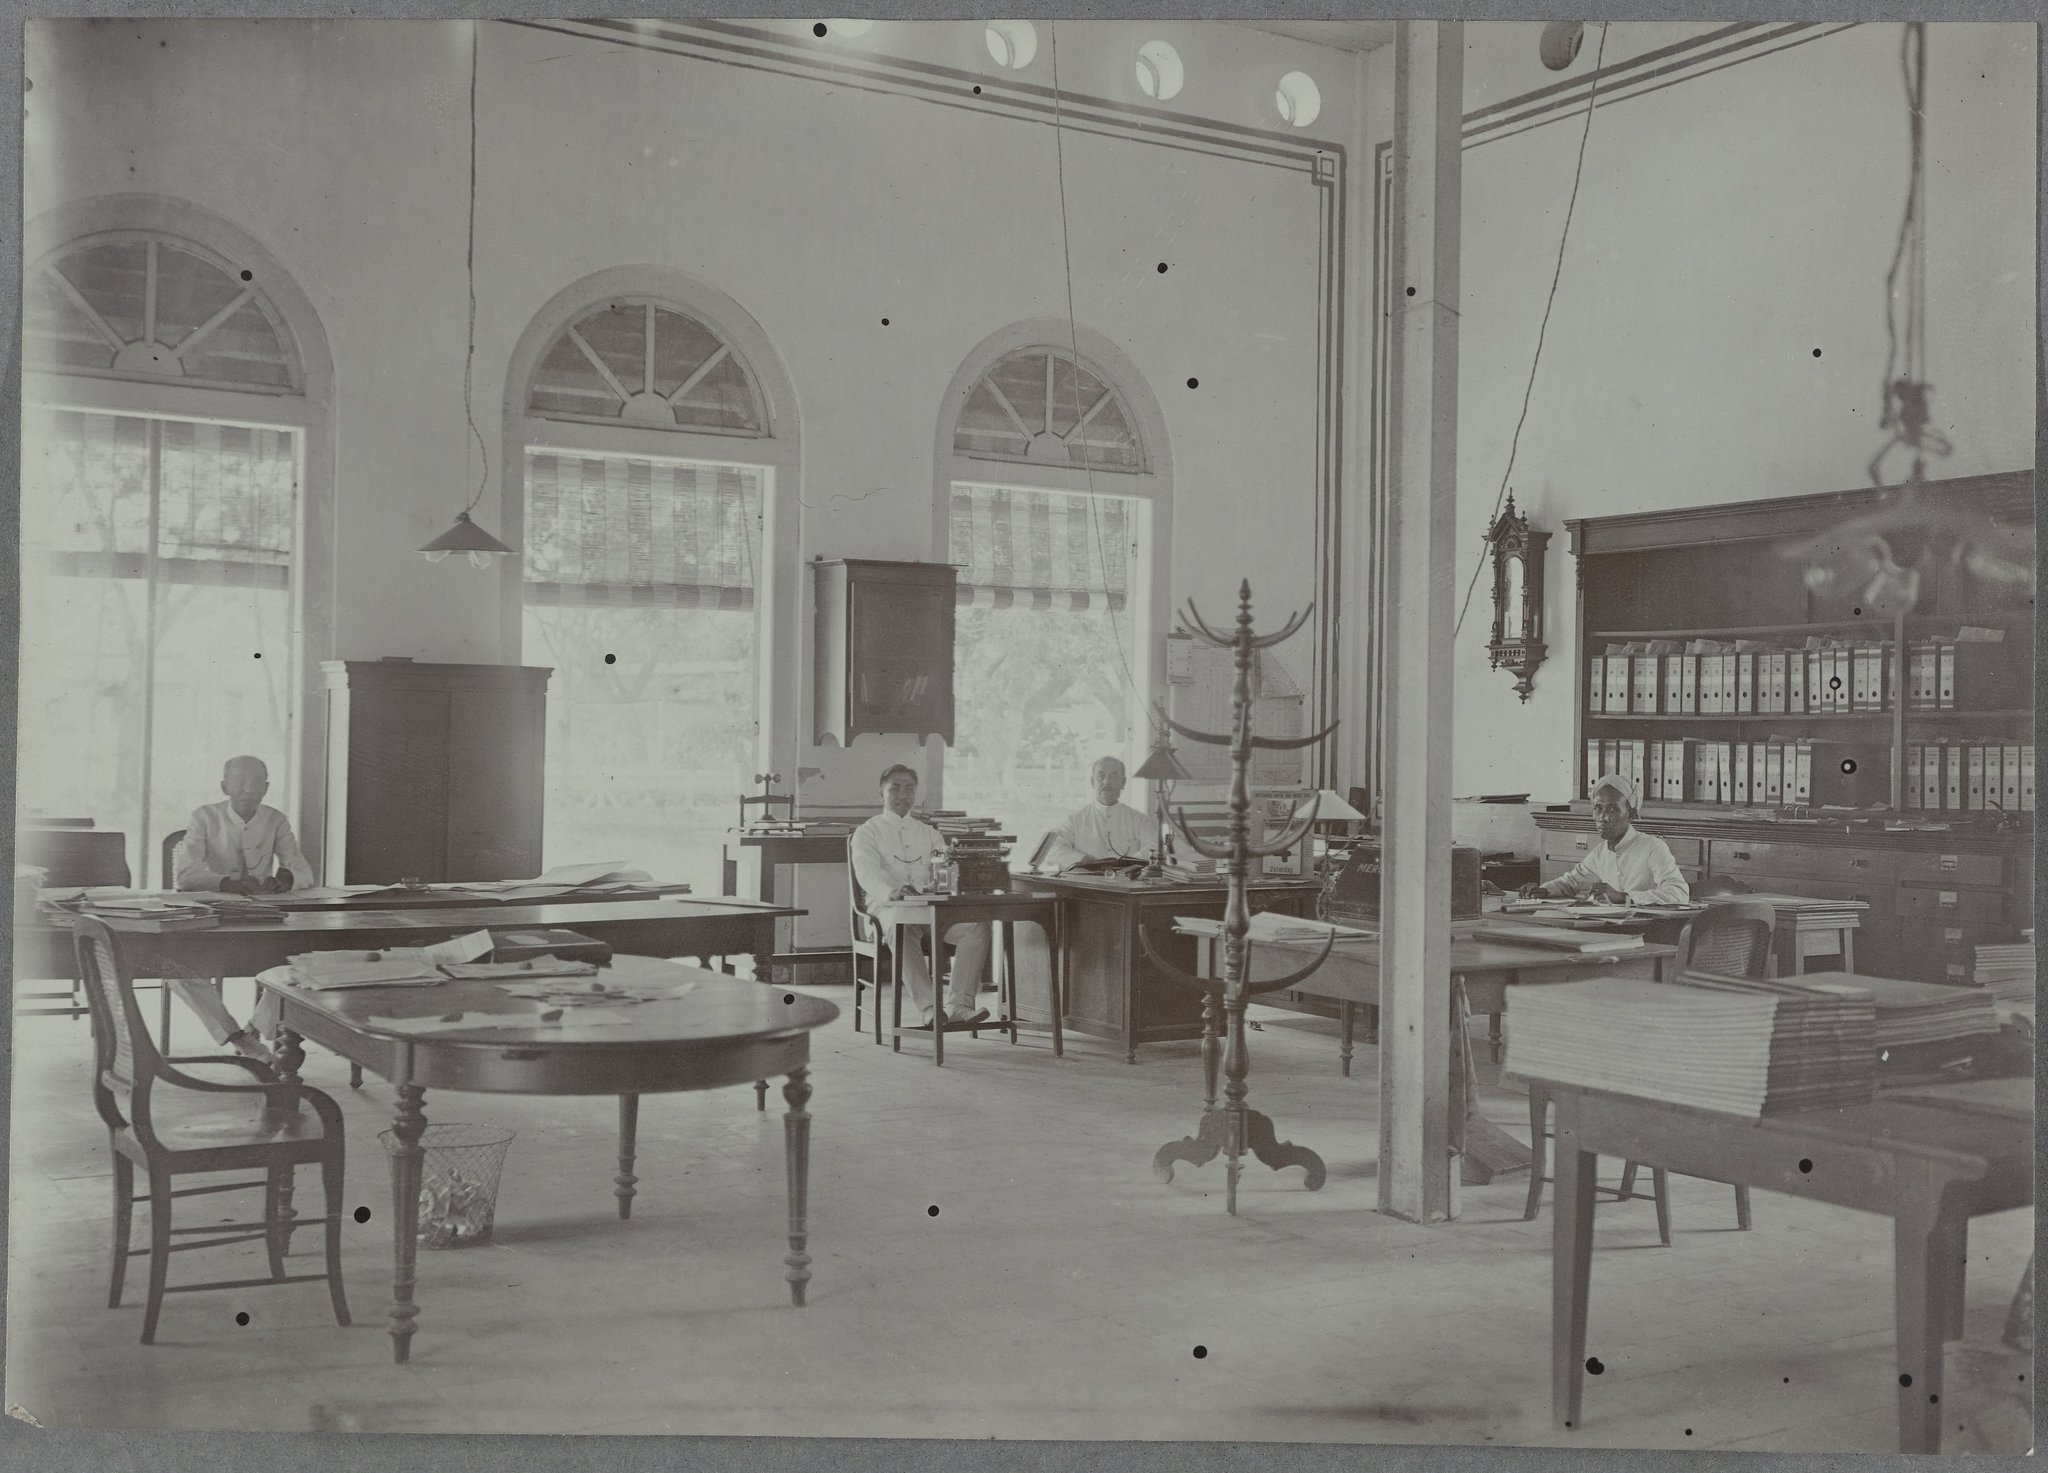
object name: photograph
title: Kantoor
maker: Anonymous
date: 1900-1907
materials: photographic support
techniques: gelatin silver print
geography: comal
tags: colonial system, (non-fruit) products of plants or trees: sugarcane, interior of industrial structures (regardless of the materials processed or the products made, office (~ administration)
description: Gezicht in een kantoor met verschillende bureaus. Onderdeel van het fotoalbum van de Tjomal suikerfabriek in de periode ca. 1900-1919.